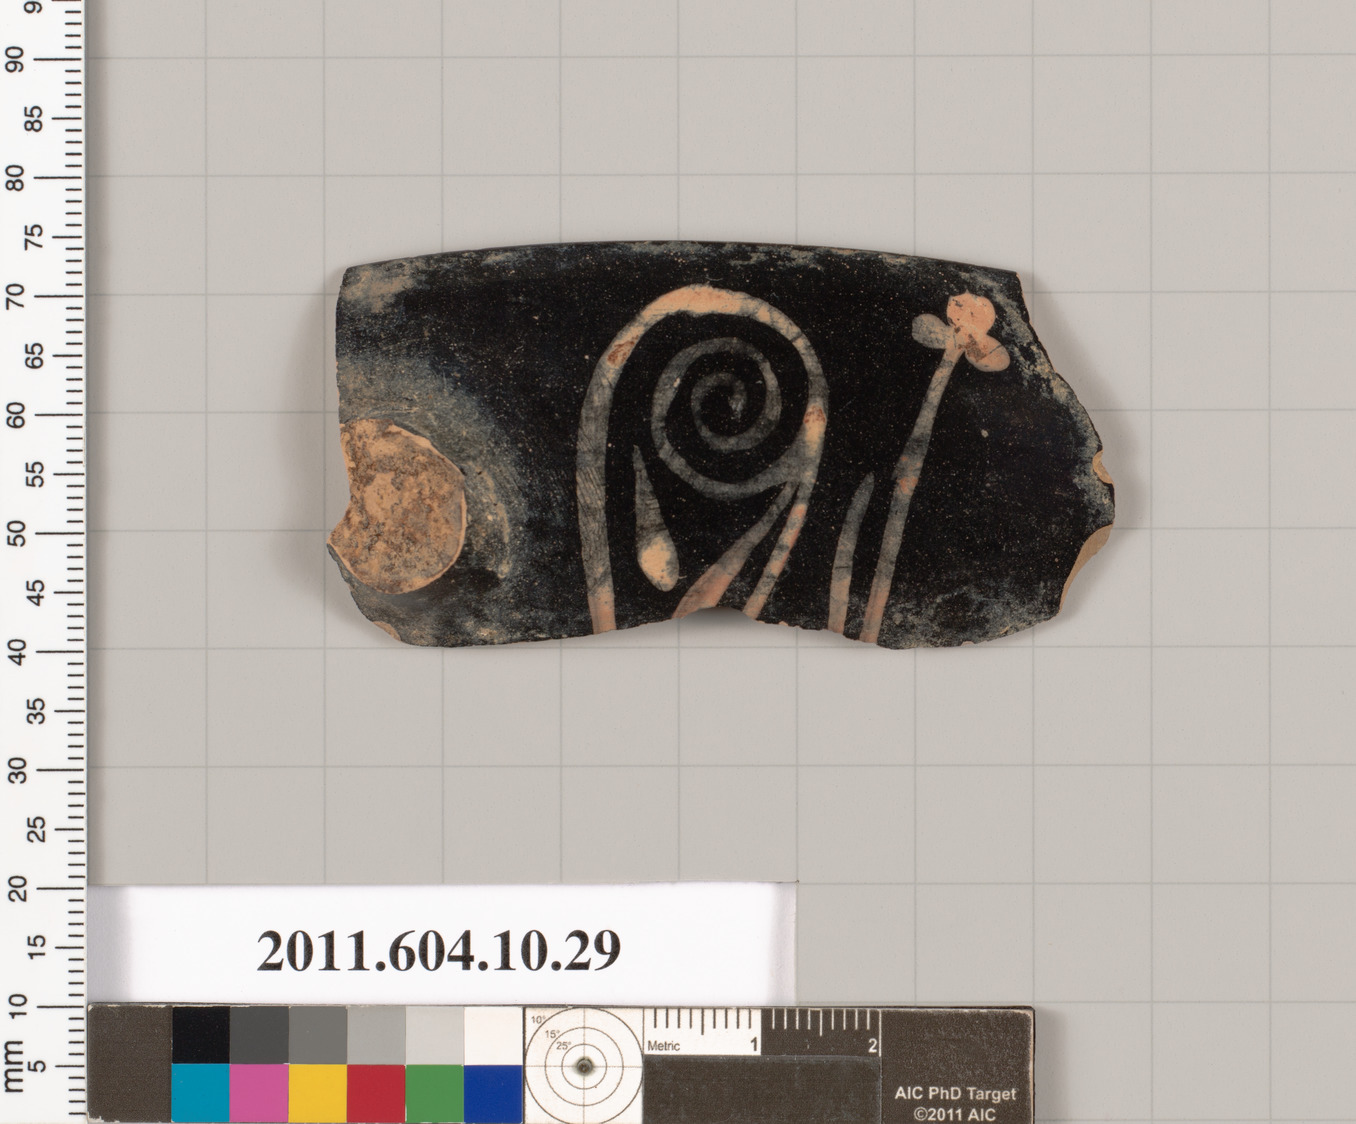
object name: kylix fragment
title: Terracotta rim fragment of a kylix (drinking cup)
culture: etruscan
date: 434-368 BCE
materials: terracotta